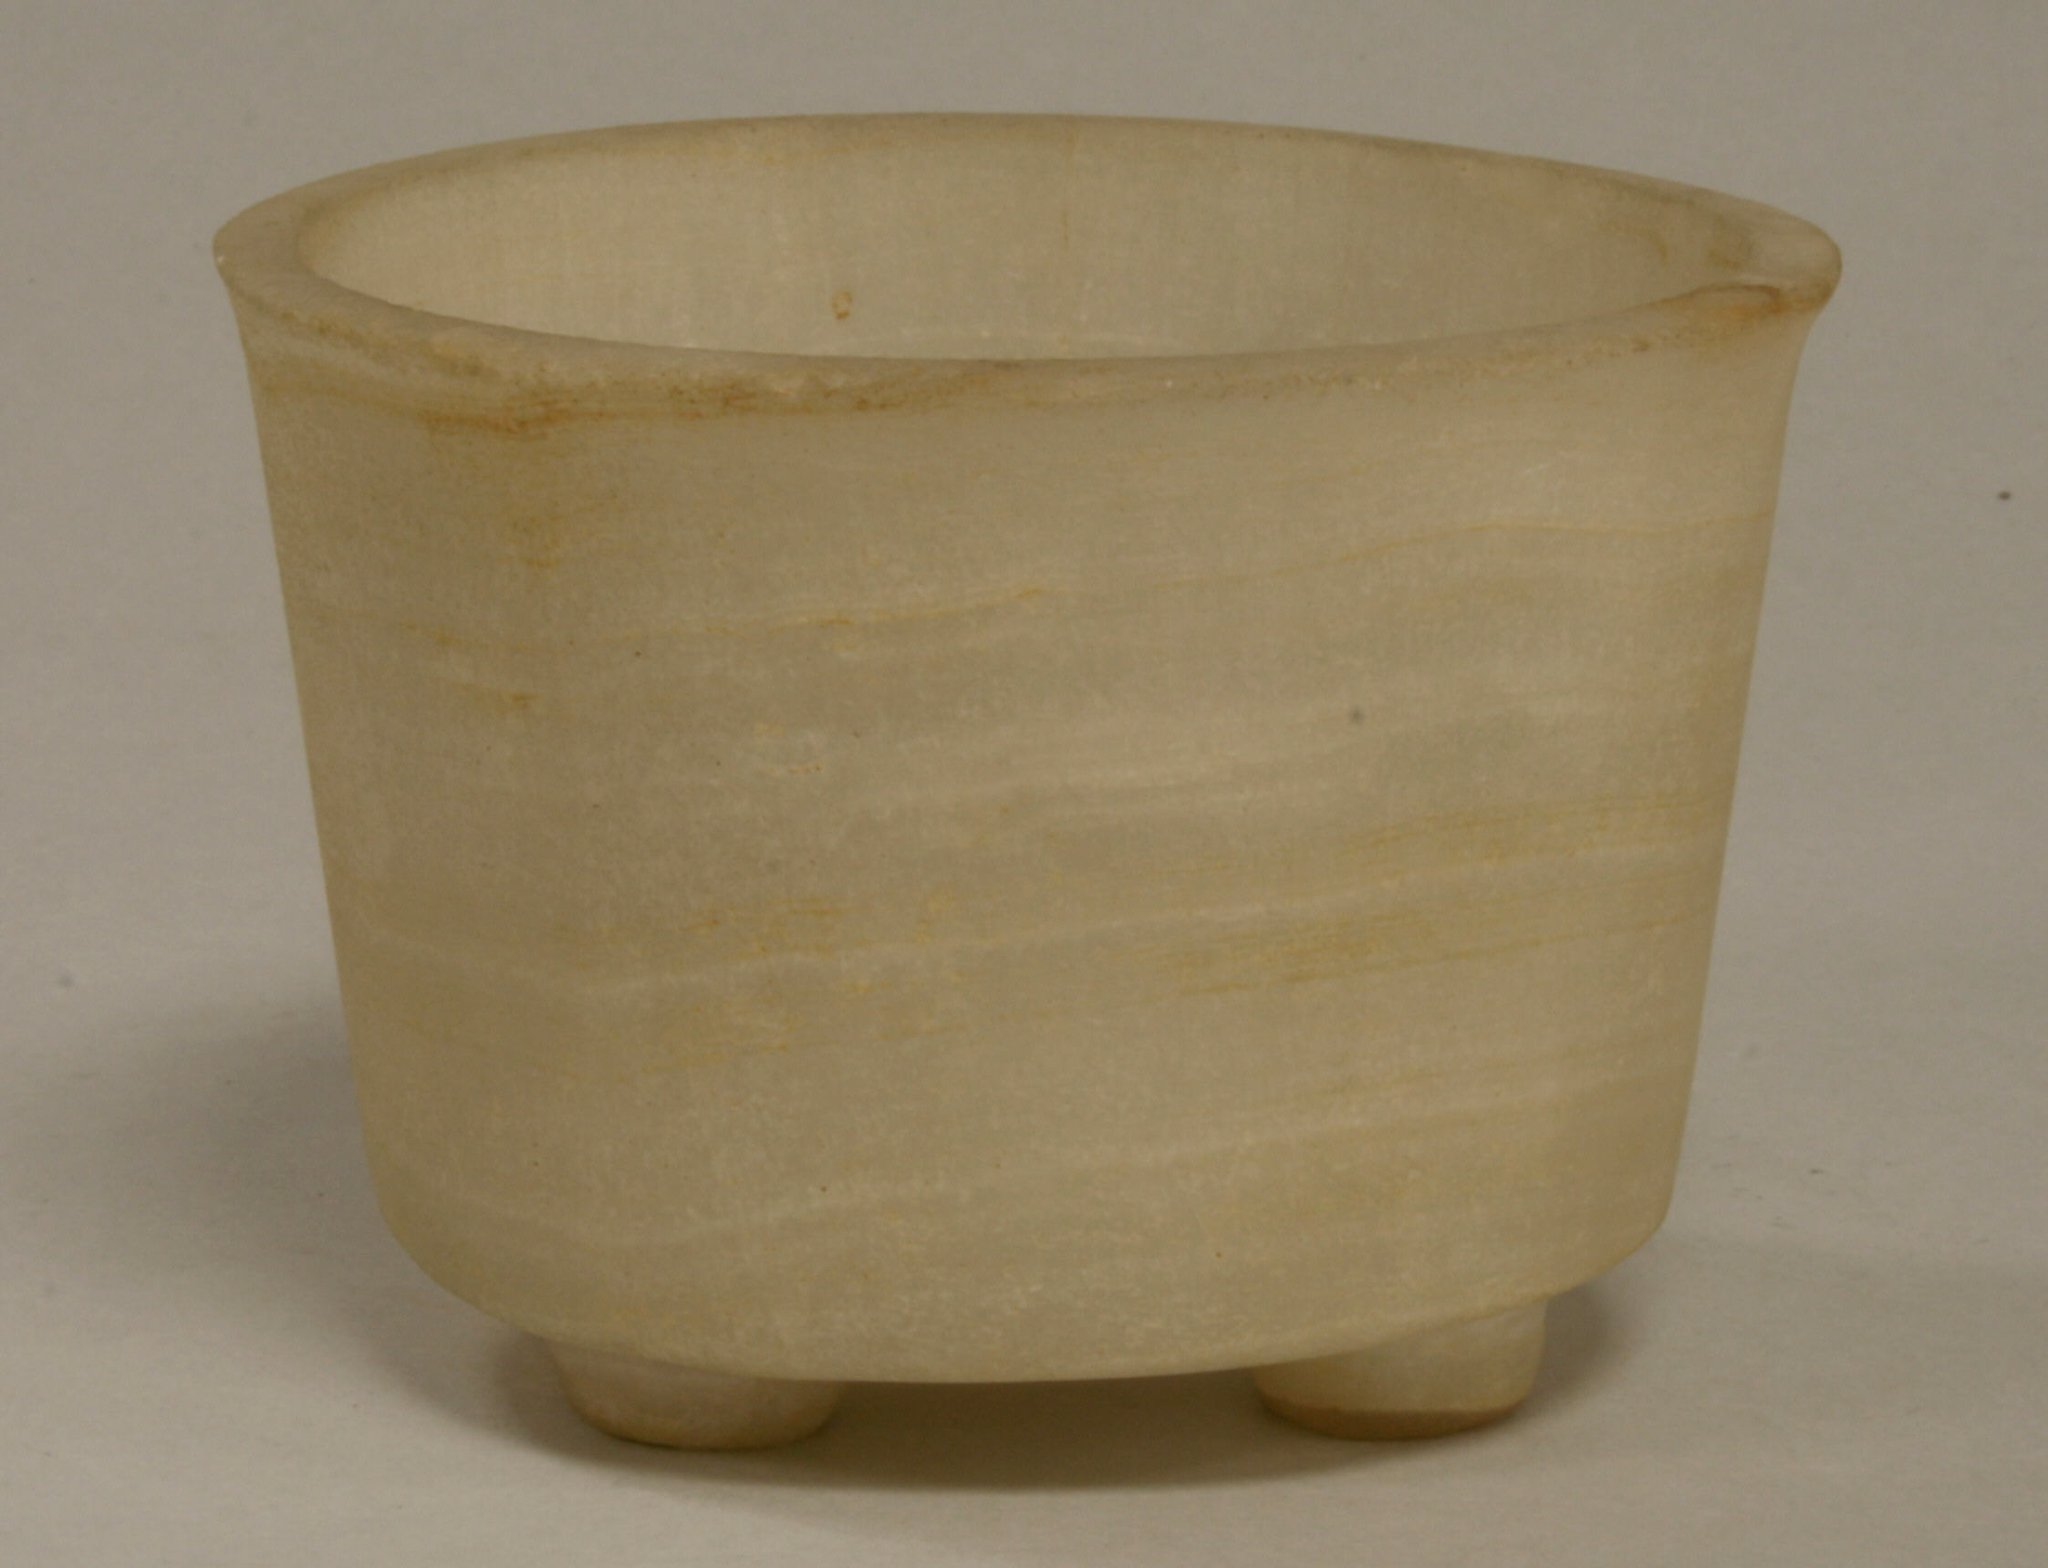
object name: vessel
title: Onyx Tripod Vessel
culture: mixtec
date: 1201-1500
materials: marble, onyx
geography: mexico